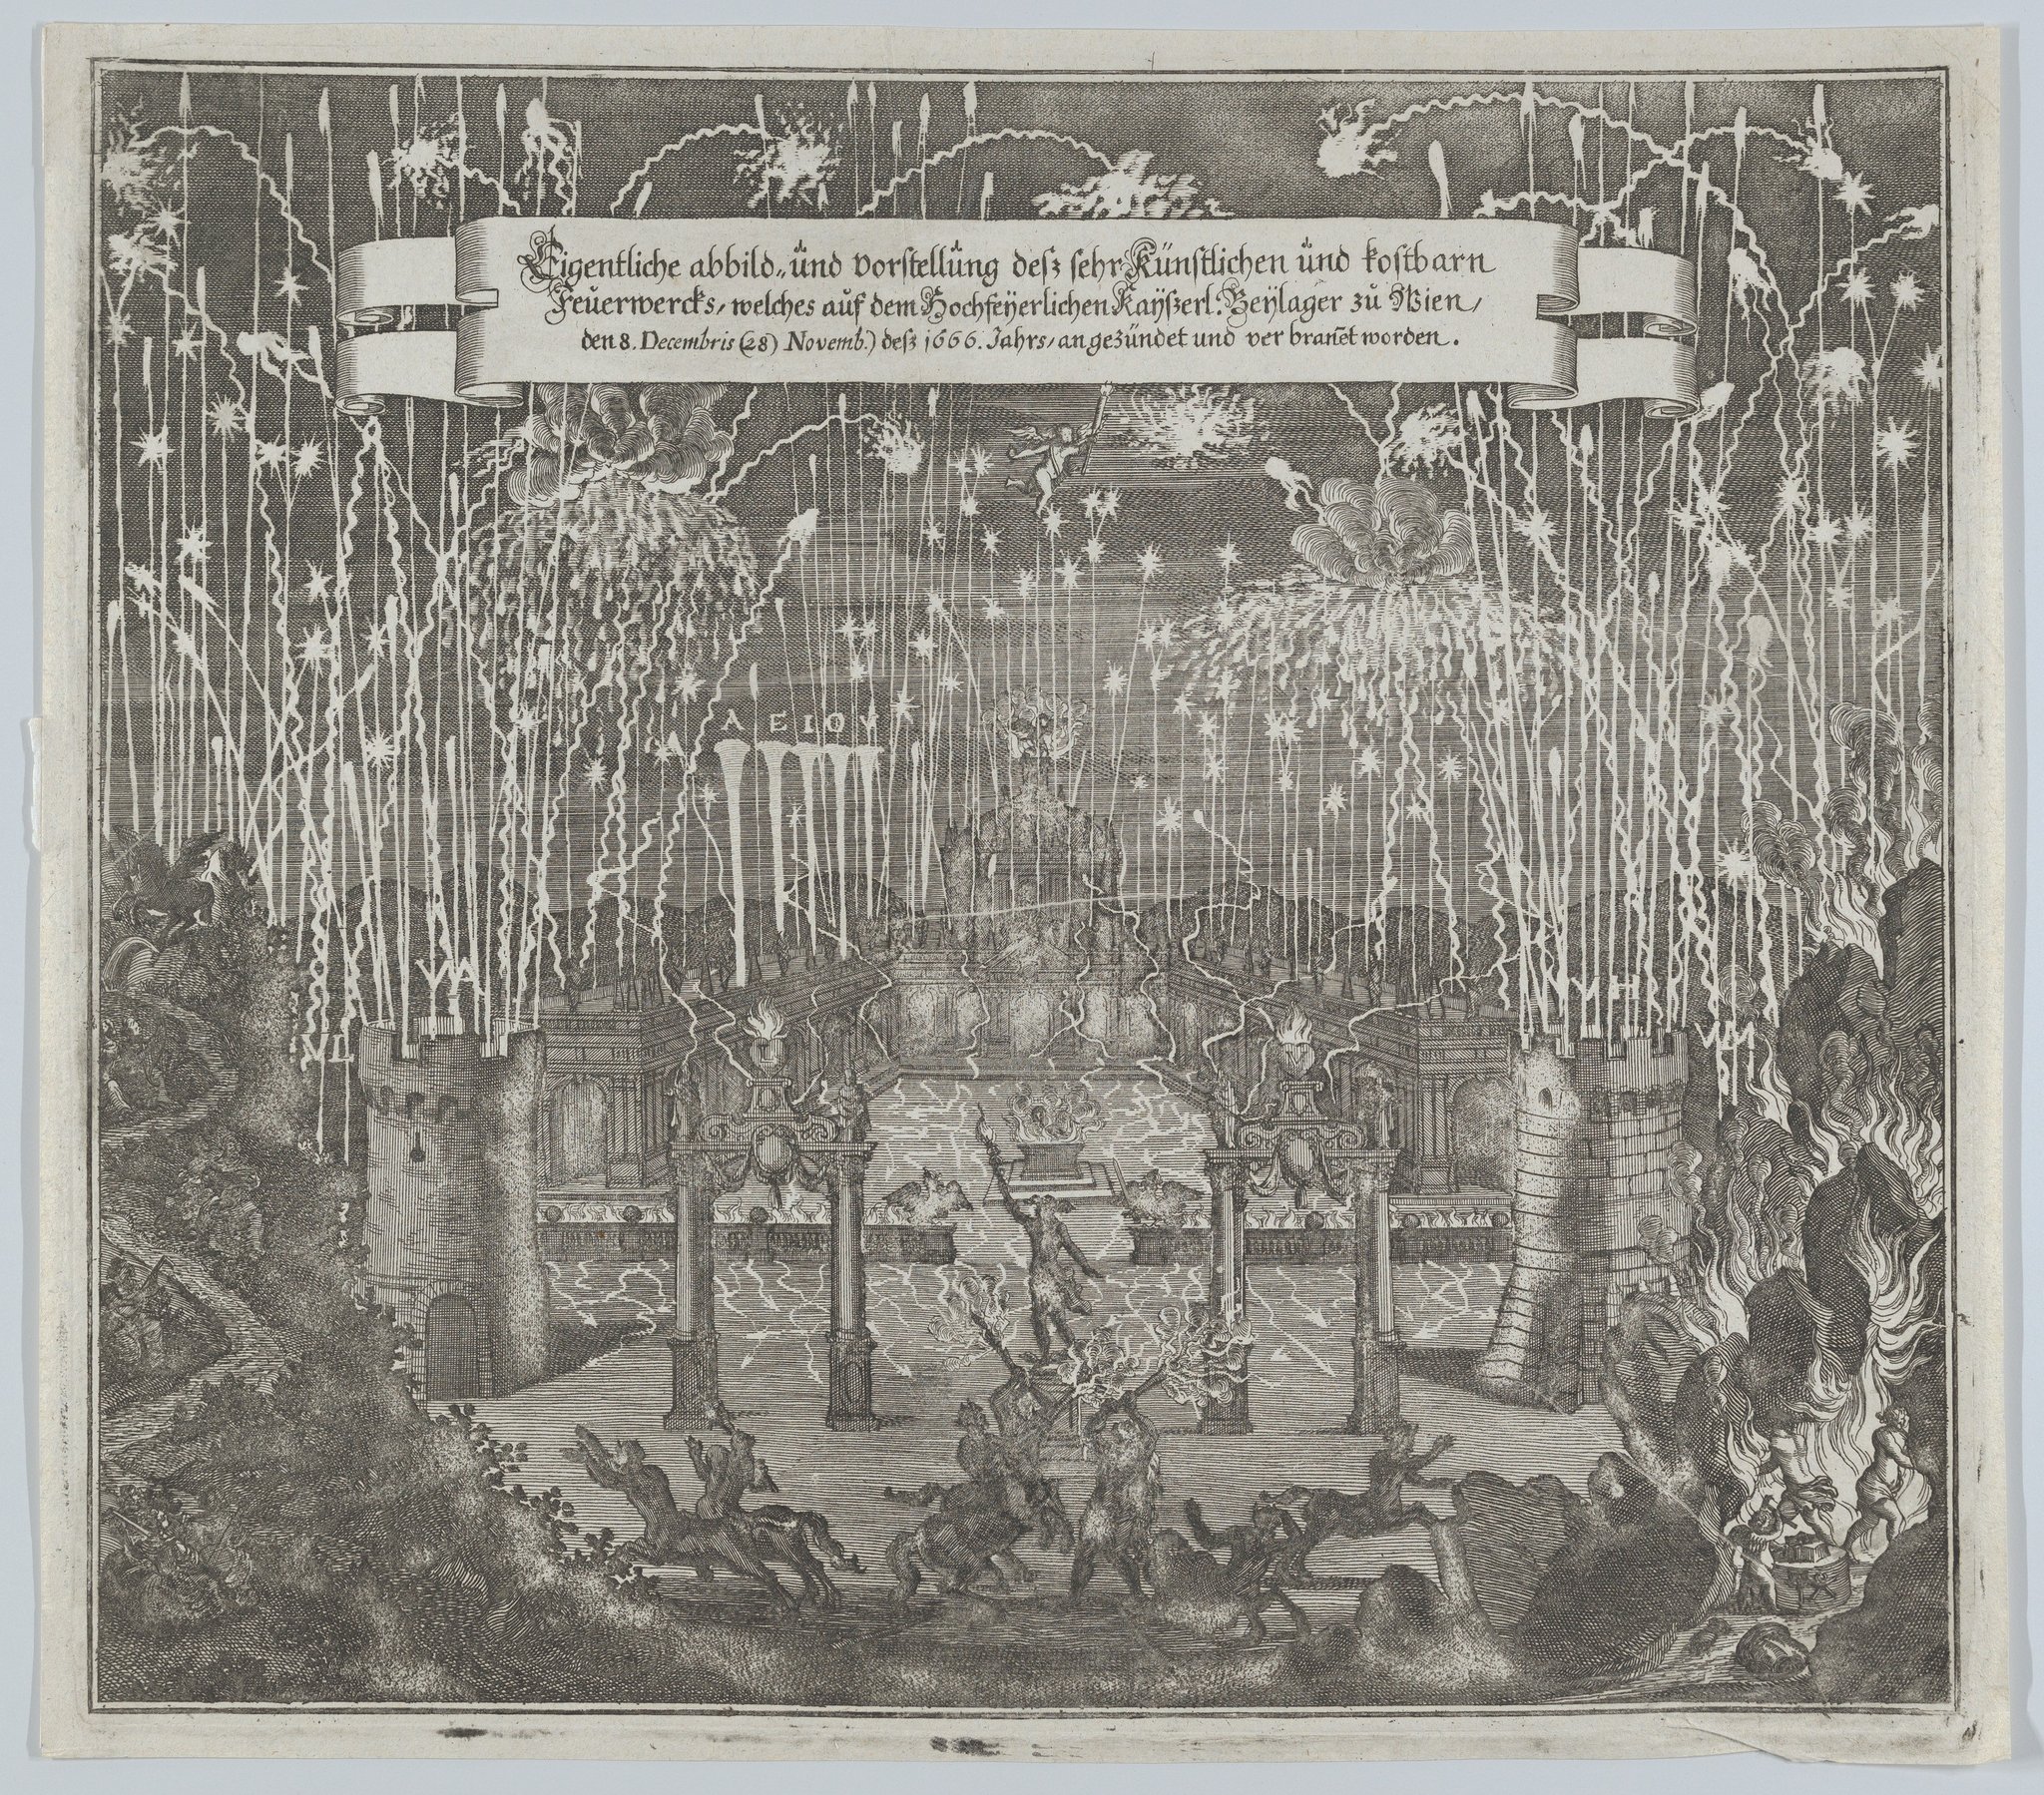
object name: print, fete, ornament architecture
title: Fireworks celebrating the marriage of Emperor Leopold I and Margarita, Vienna 1666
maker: melchior küsel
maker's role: artist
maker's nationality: german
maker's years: 1626-1683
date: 1666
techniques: engraving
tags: fireworks